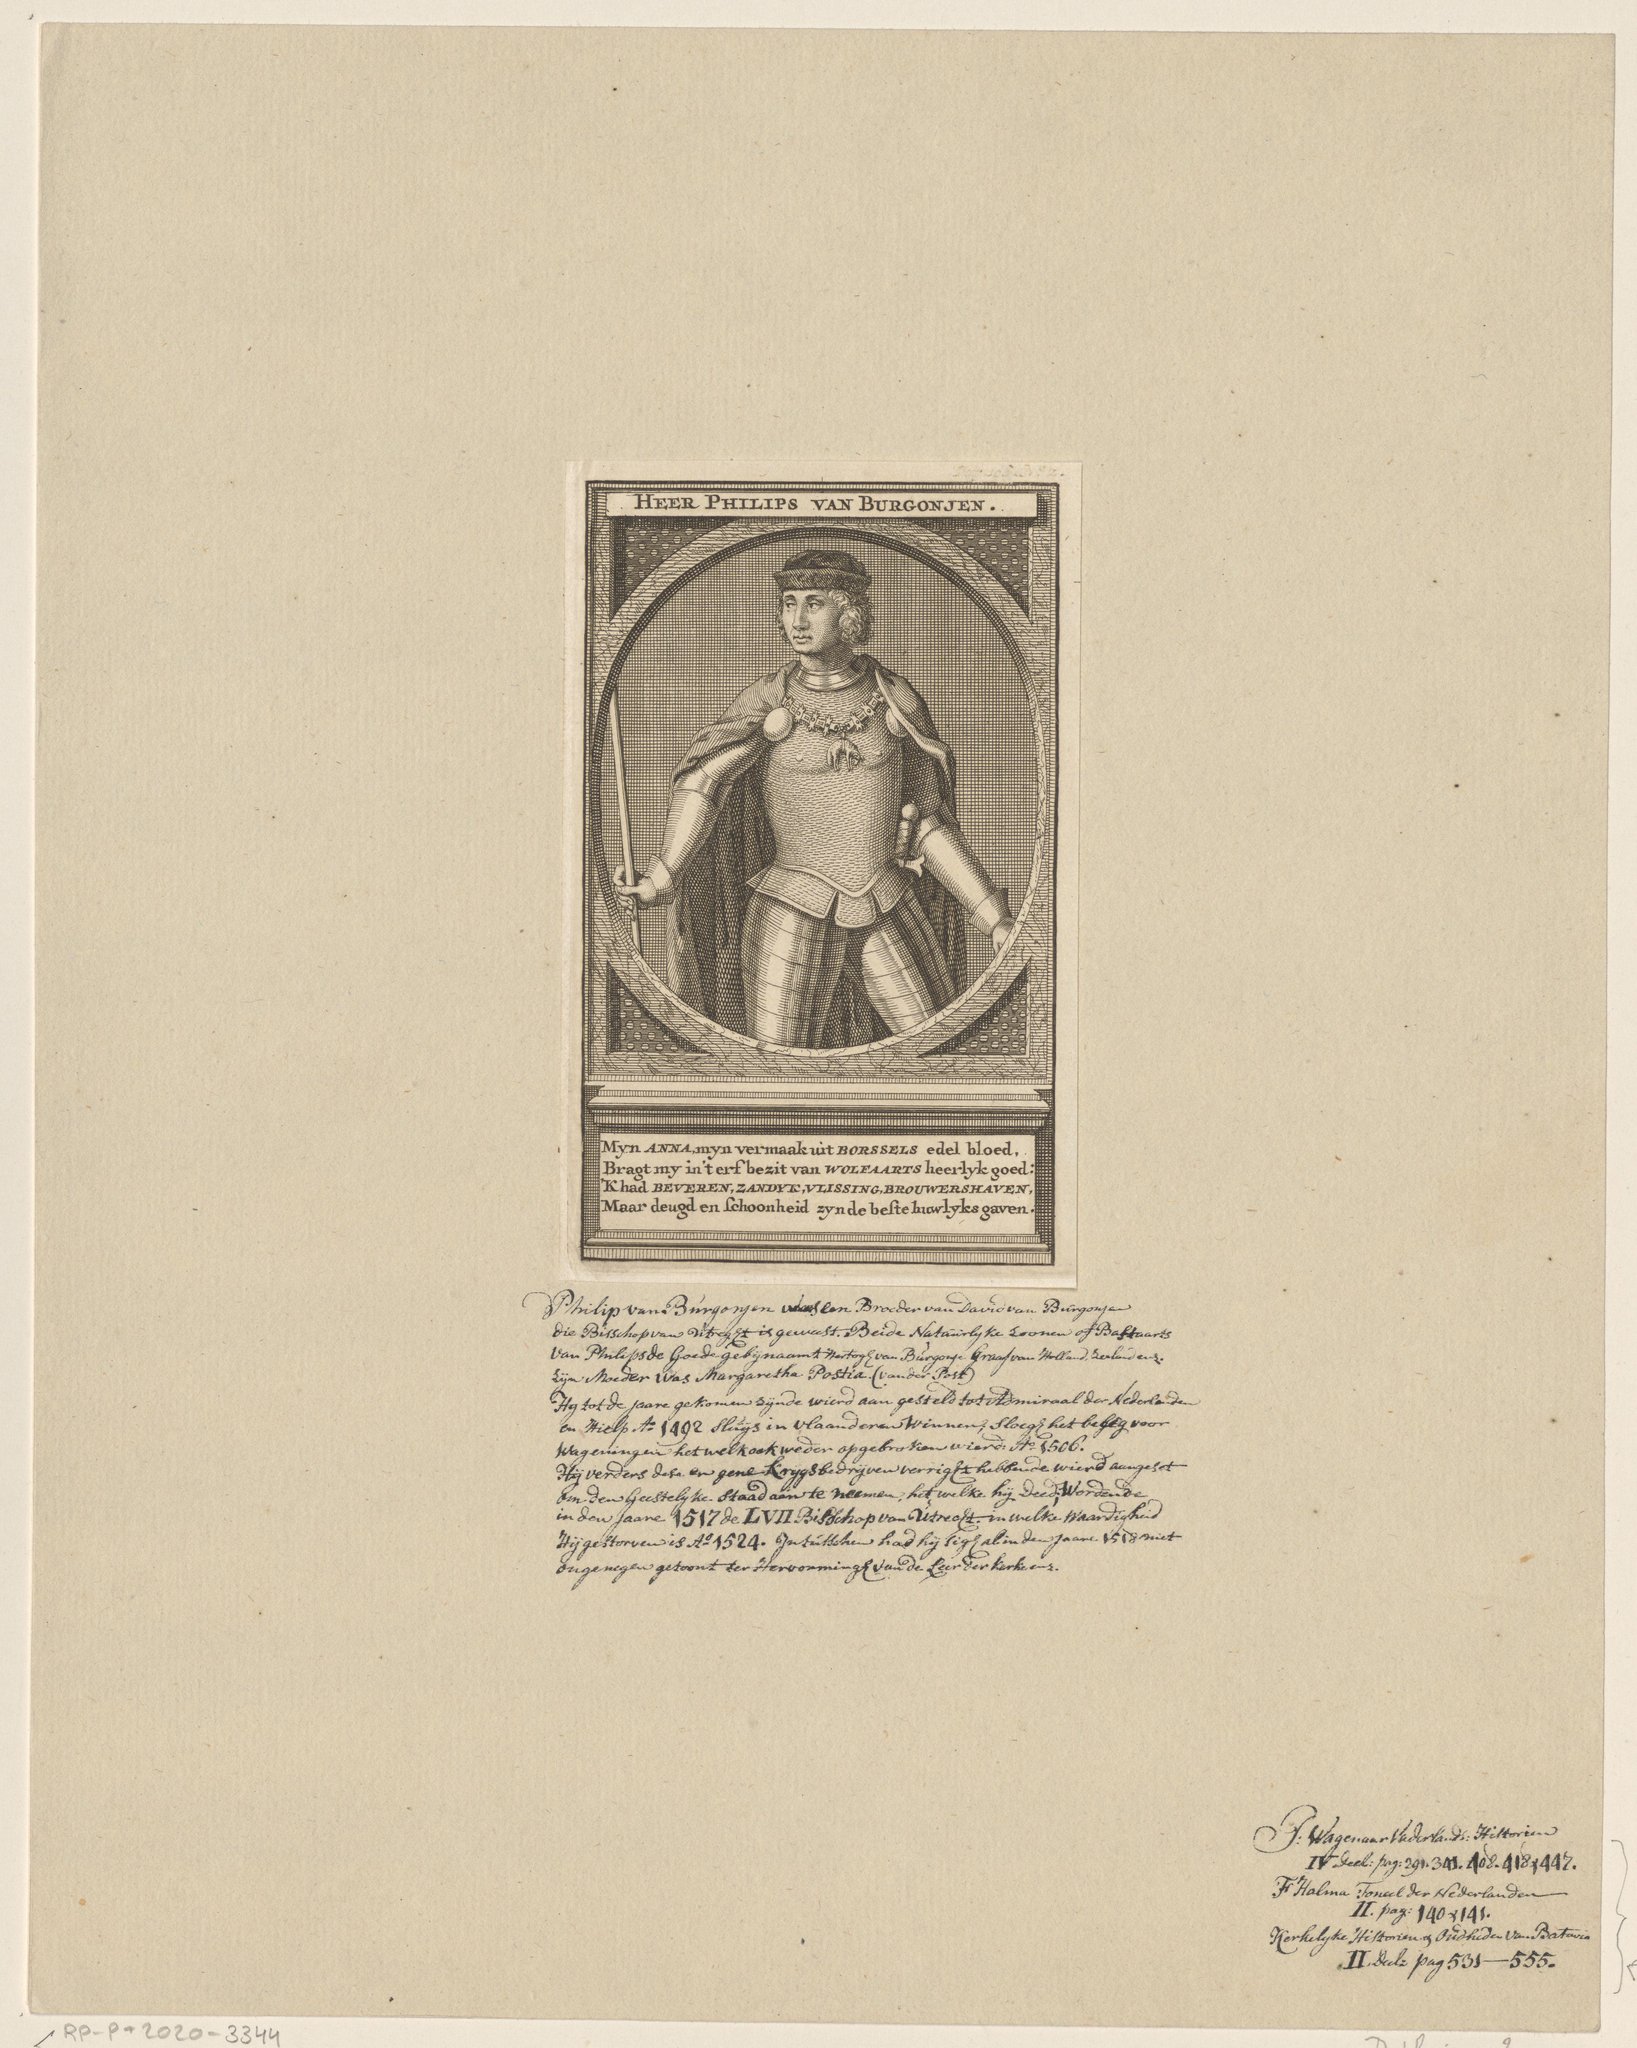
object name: print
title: Portret van Filips van Bourgondië-Beveren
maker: Anonymous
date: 1700-1749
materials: paper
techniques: engraving, etching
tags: armour, historical persons, knighthood order of the golden fleece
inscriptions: inscription: ‘Philip van Burgonjen den broeder van David van Burgonjen (...)’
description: Prent met paginanummer rechtsboven gebruikt in: Gargon, Mattheus. Walchersche Arkadia. Leiden: Samuel Luchtmans, 1717. Prent ook gebruikt in latere edities van dit werk.